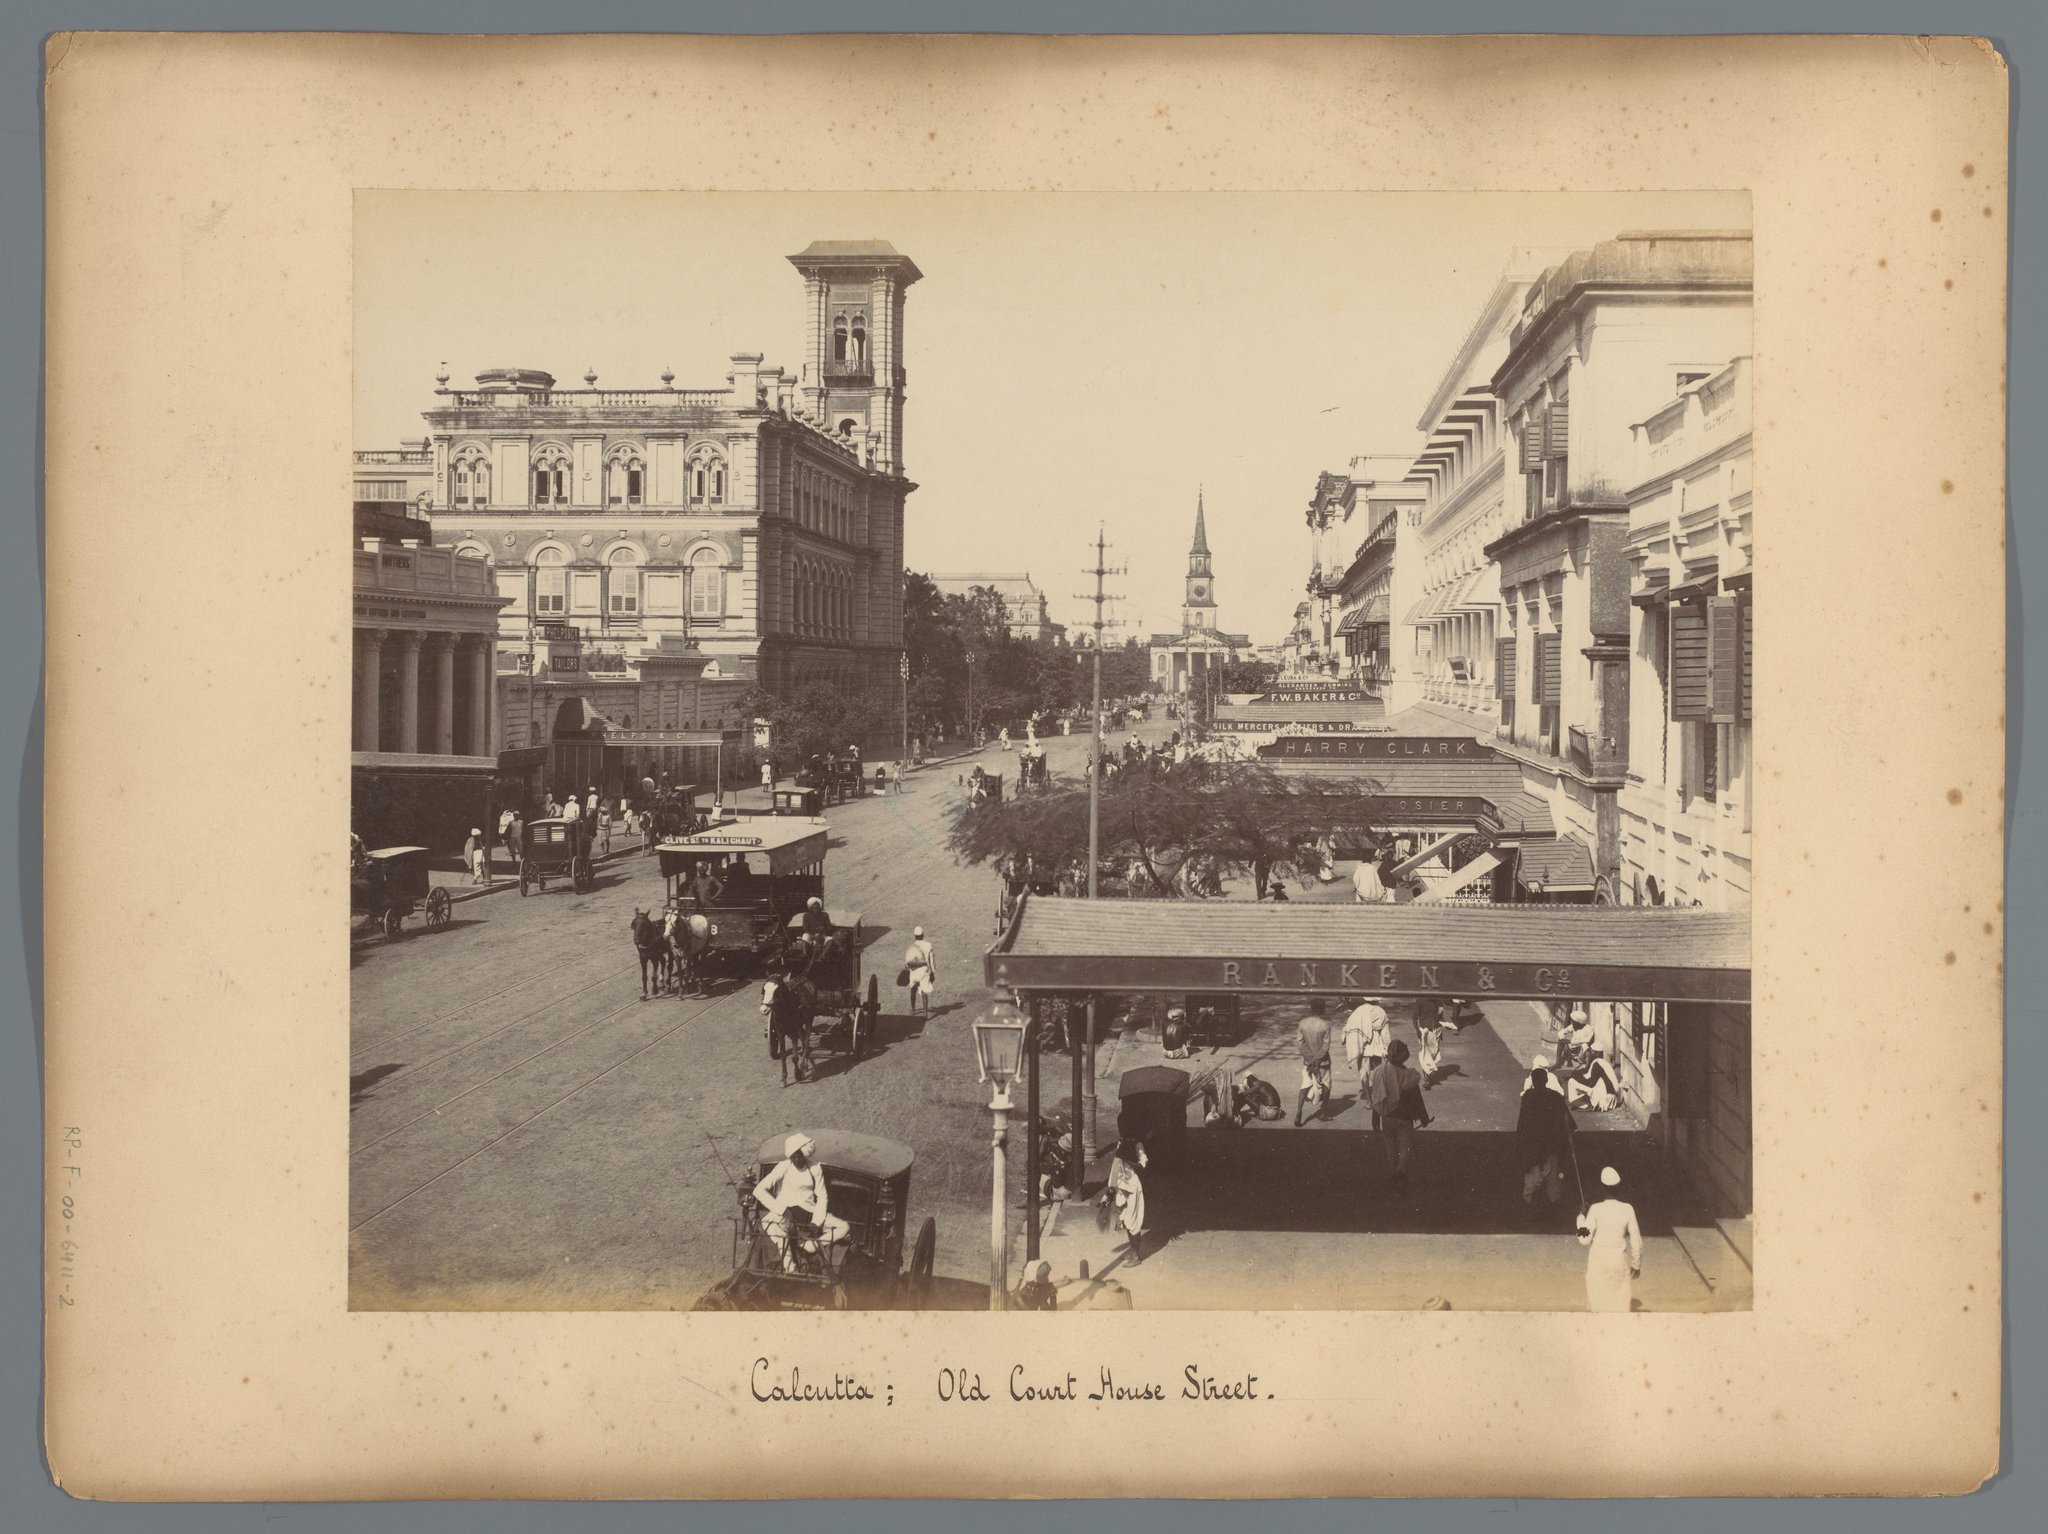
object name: album leaf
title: View of the Old Court House Street, Kolkata, West Bengal, India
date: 1863-1880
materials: cardboard, photographic support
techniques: albumen print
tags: kolkata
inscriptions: caption: ‘Calcutta; Old Court House Street.’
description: Gezicht op een straat met links en rechts winkels, en paardenkoetsen en mensen op straat, Calcutta, India. Calcutta (officieel: Kolkata) is de hoofdstad van de deelstaat West-Bengalen.